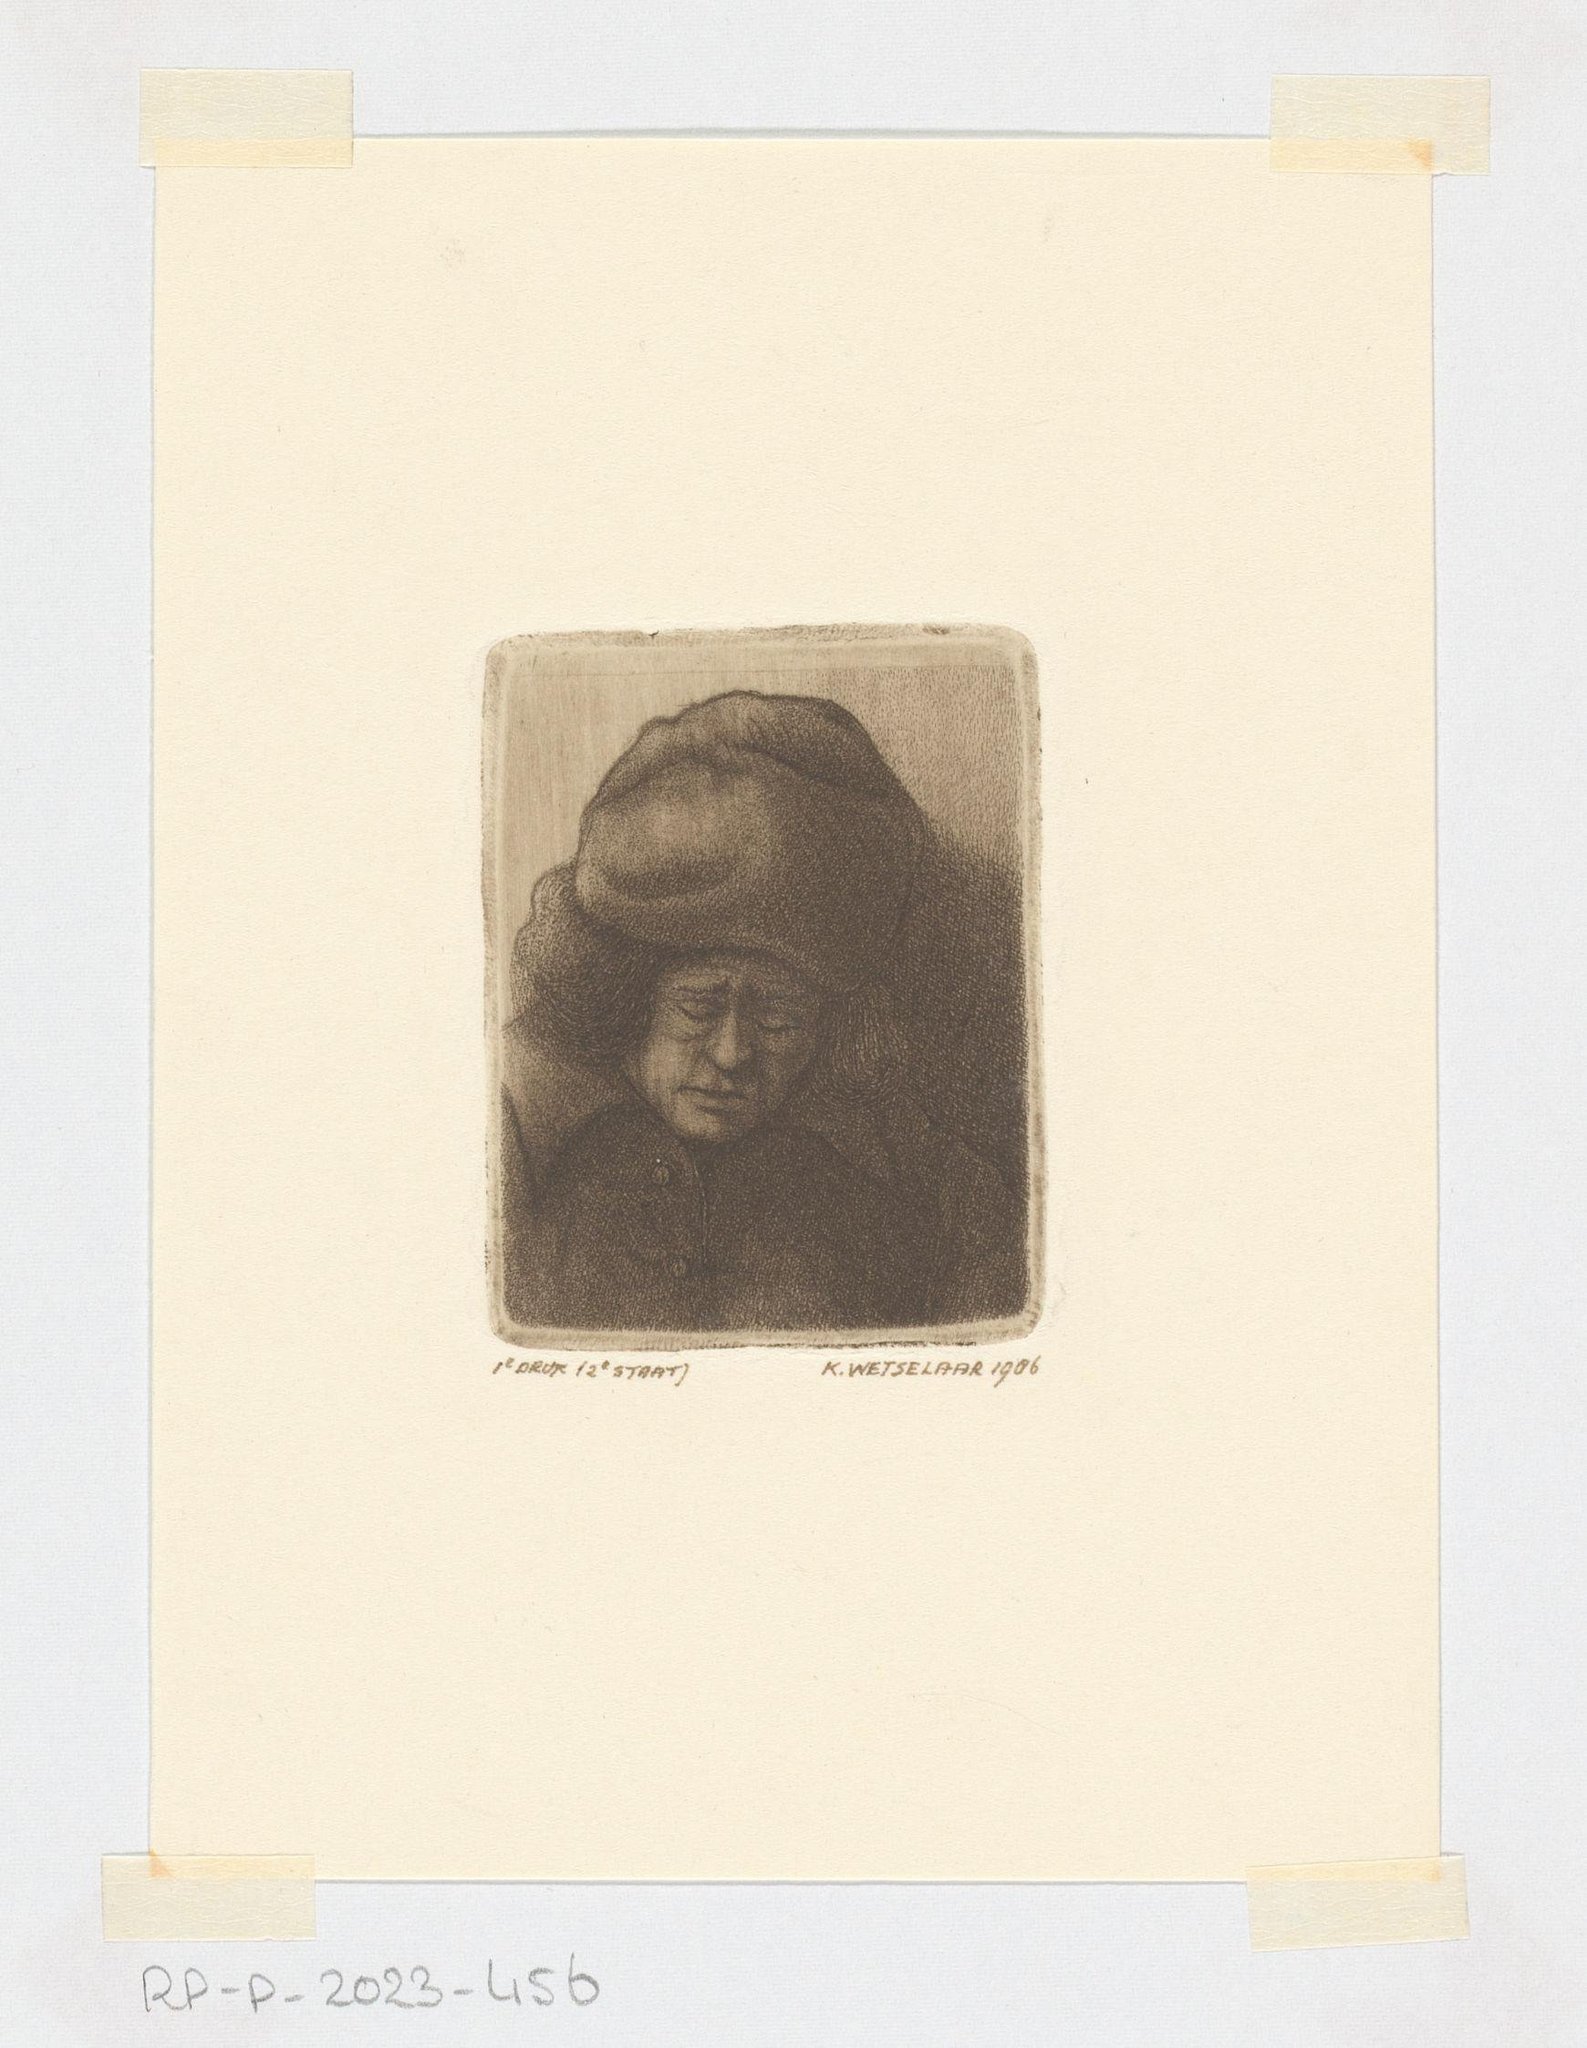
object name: print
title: Portret van een oudere vrouw in een gekraagde jas met een hoed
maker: karel wetselaar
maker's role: print maker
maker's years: 1935-2017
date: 1986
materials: paper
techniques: etching, intaglio, retroussage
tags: head-gear, coat, anonymous historical person portrayed alone - bb - woman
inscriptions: signature and date: ‘K. Wetselaar 1986’, inscription: ‘1e druk (2e staat)’